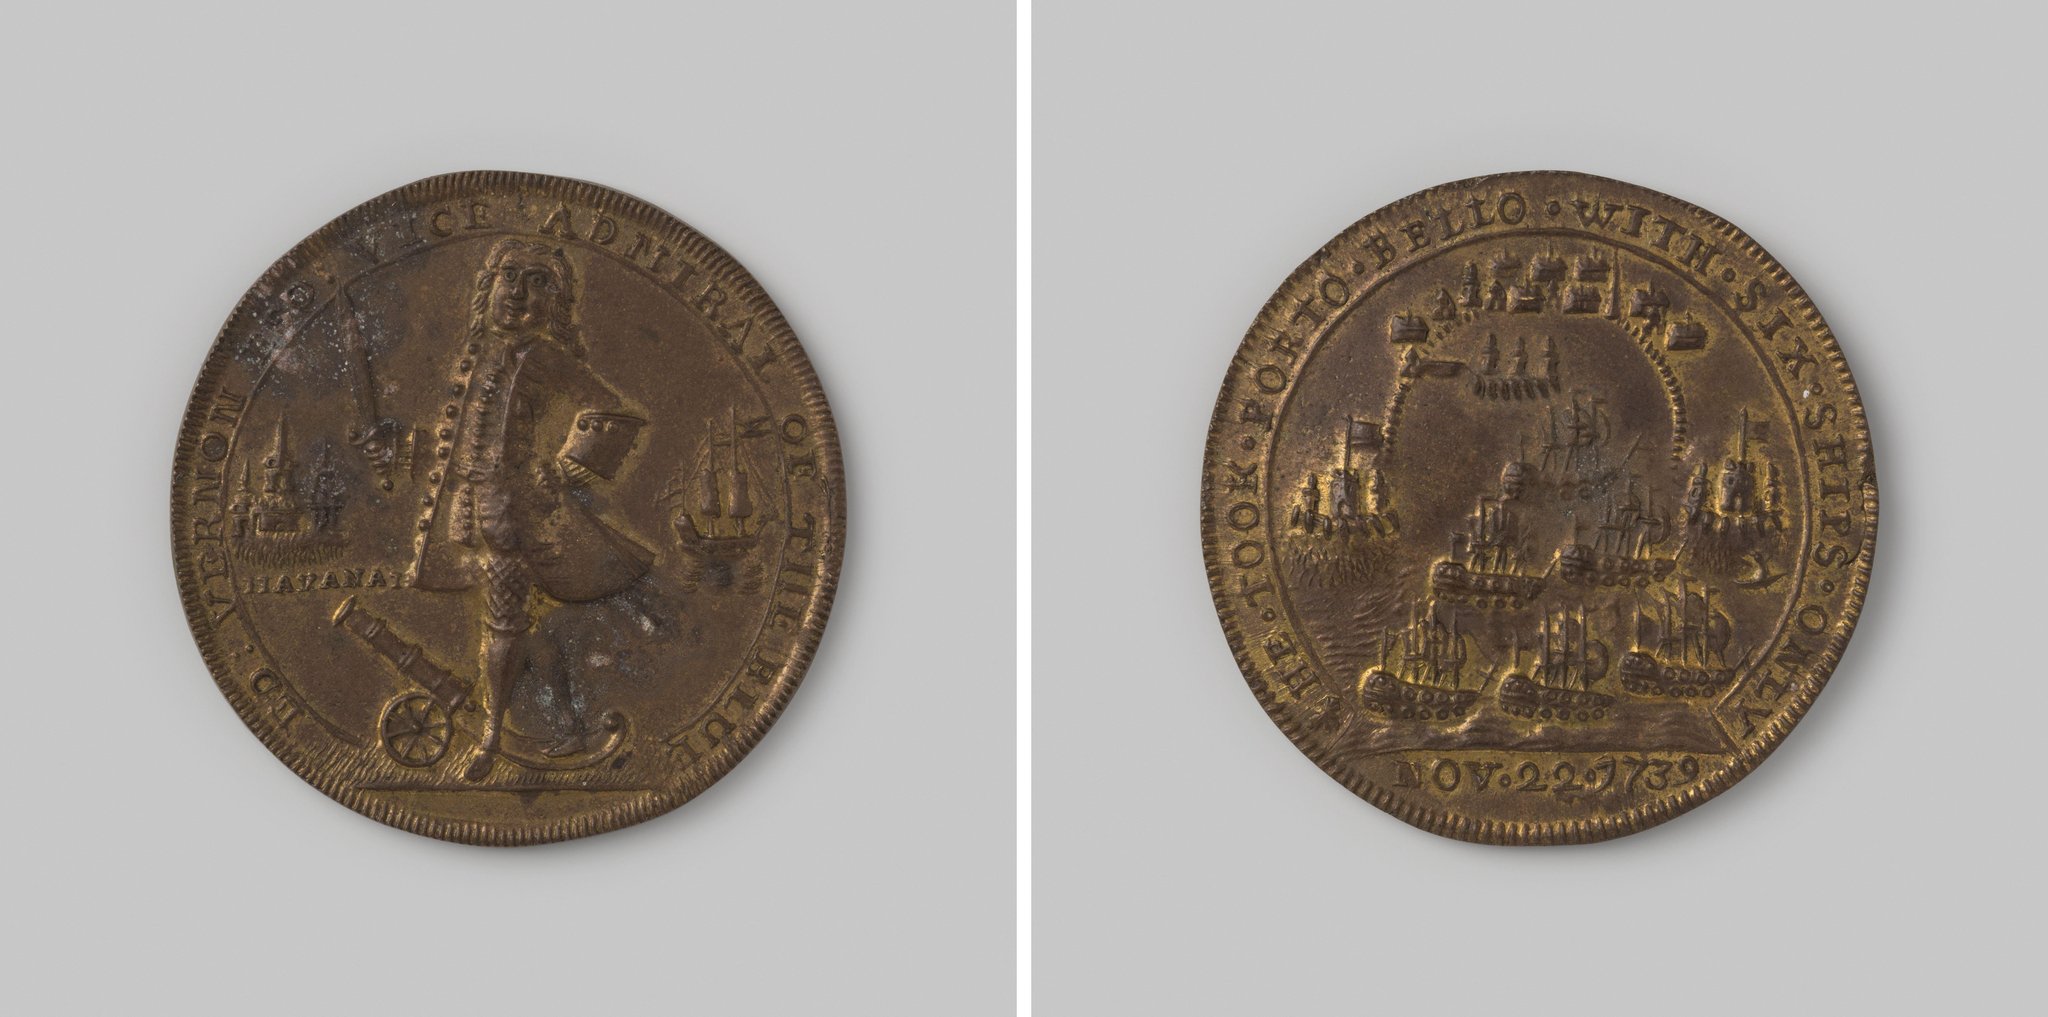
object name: history medal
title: Inname van Porto-Bello door Admiraal Vernon 1739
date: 1739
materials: brass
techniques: striking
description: Verguld messing penning, op de voorzijde Vernon staand naar links met zwaard, een kanon aan zijn voeten, tussen Havana en een oorlogsschip, met omschrift, op de keerzijde de haven van Porto Bello waarvoor zes schepen, met omschrift en afsnedetekst.